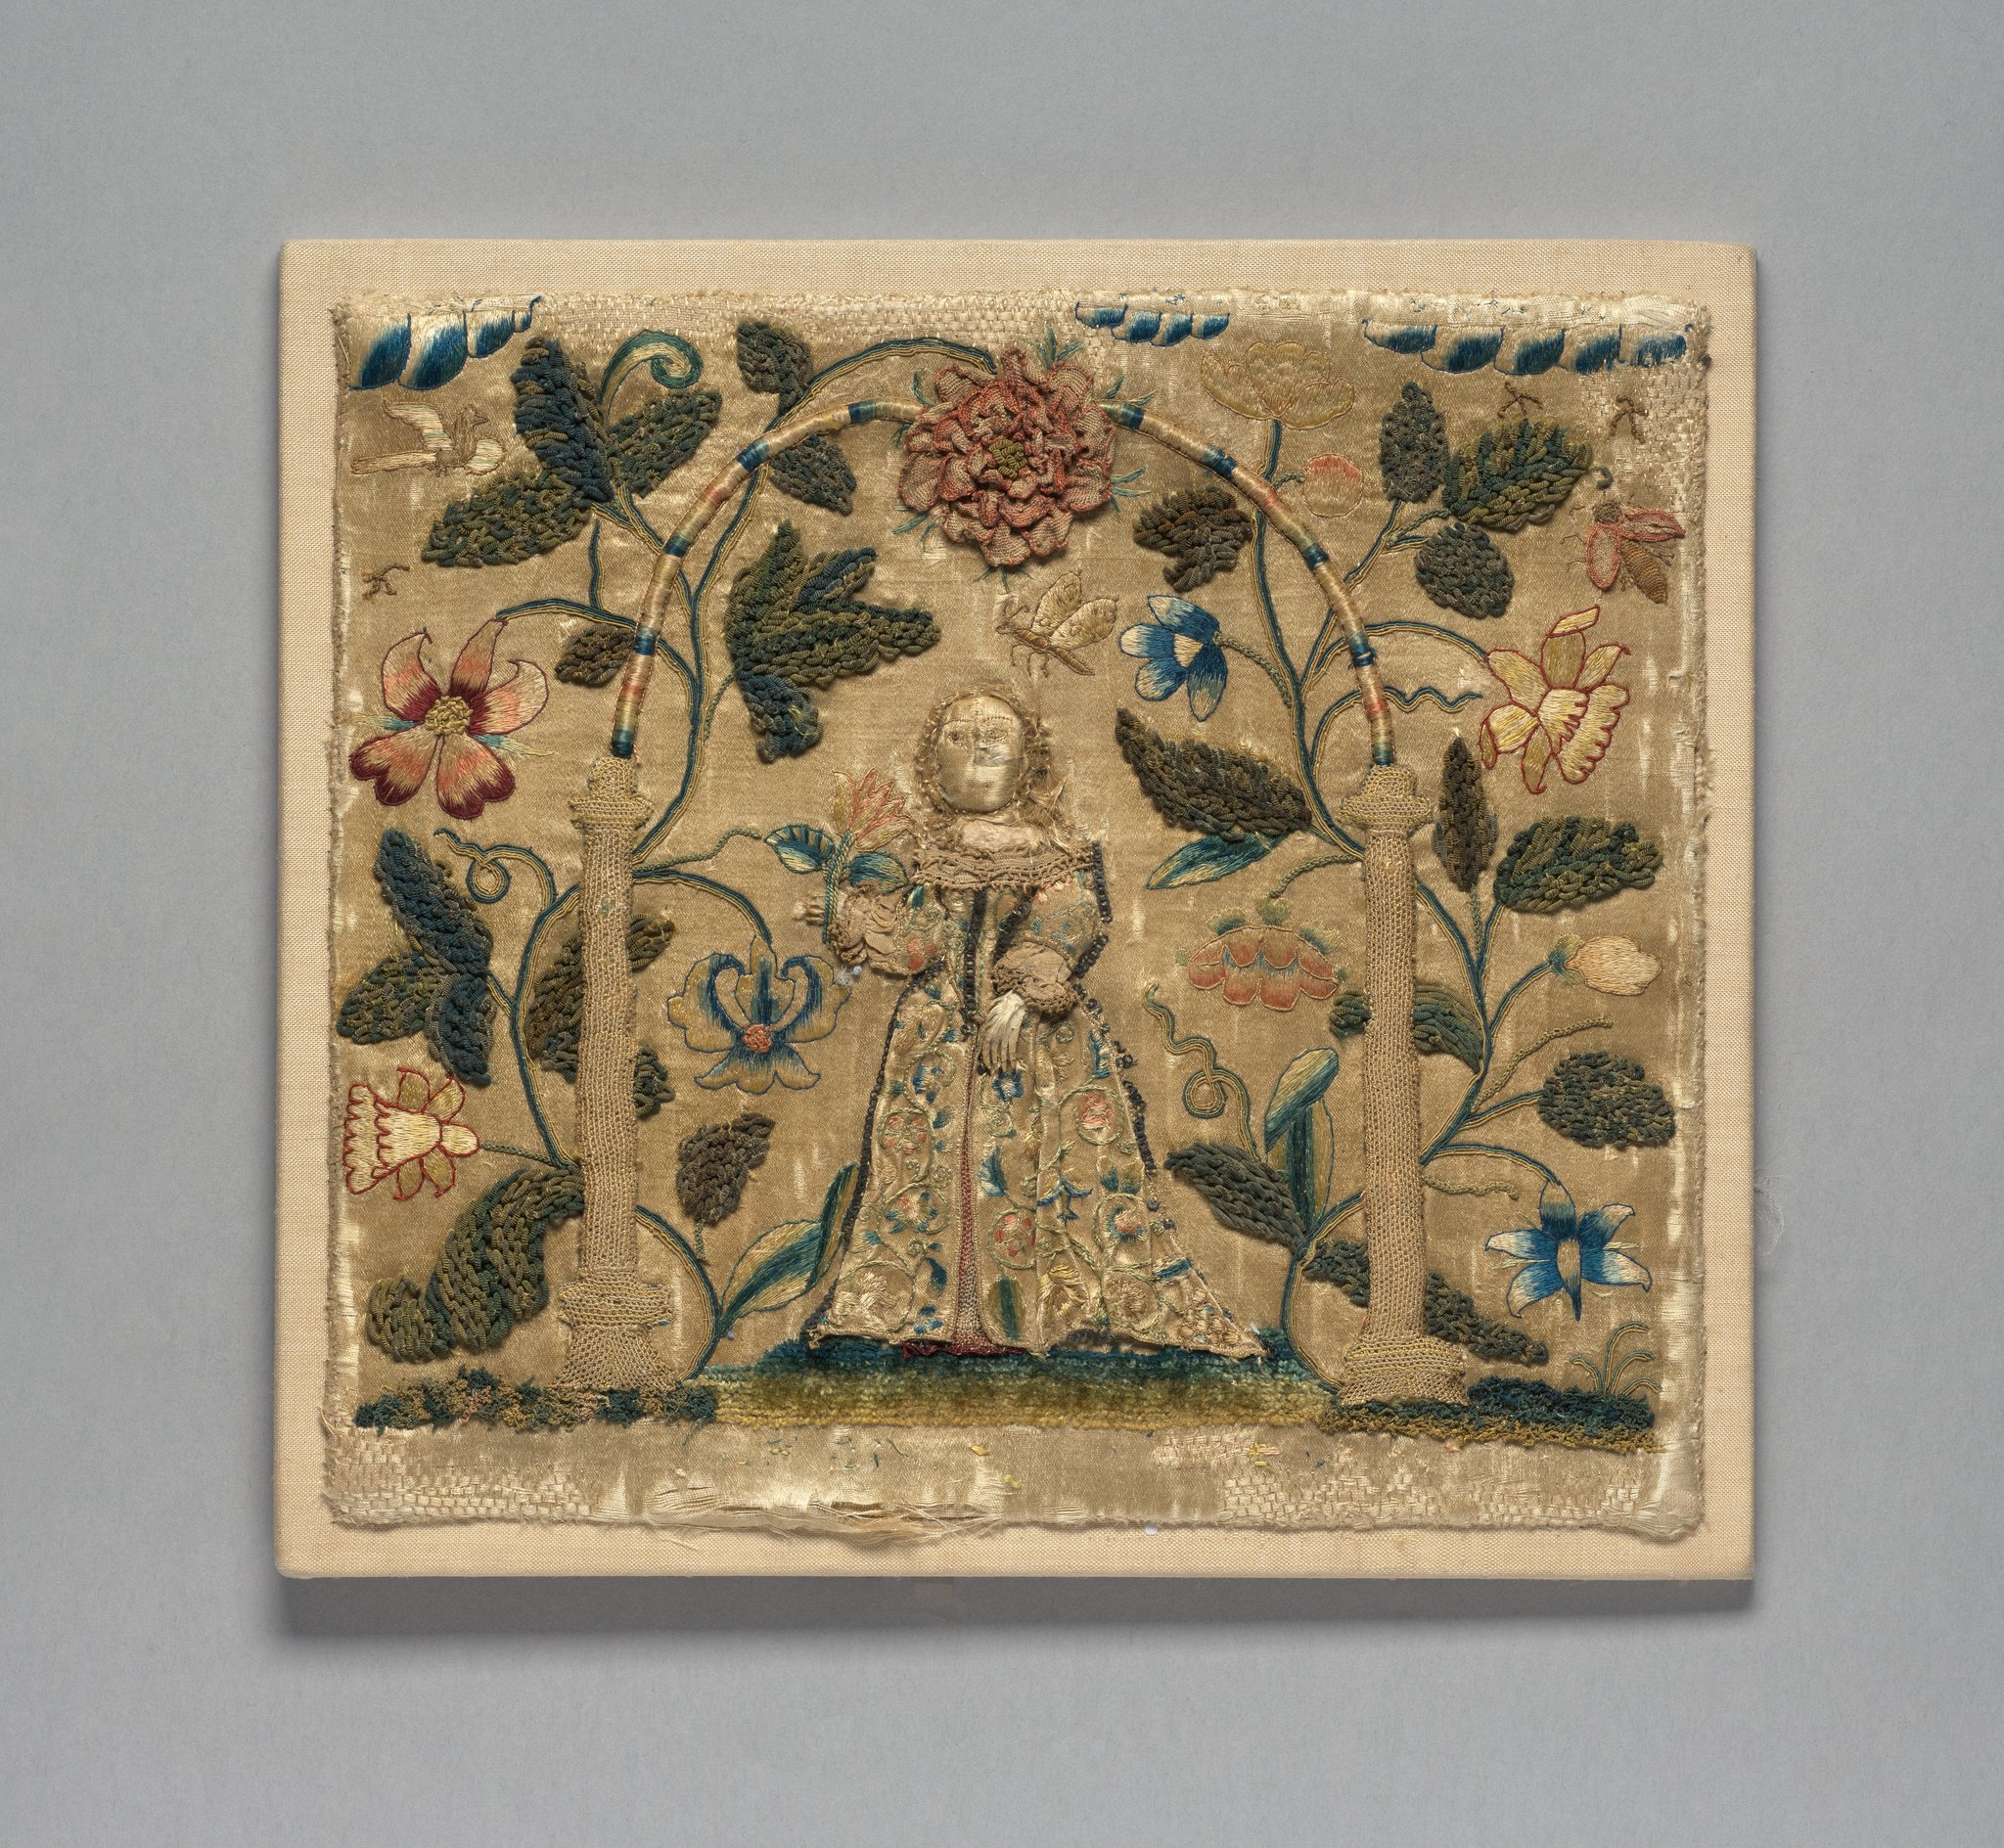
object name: embroidered picture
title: Picture with stumpwork embroidery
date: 1651-1700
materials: metal thread, silk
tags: birds,women,insects,flowers